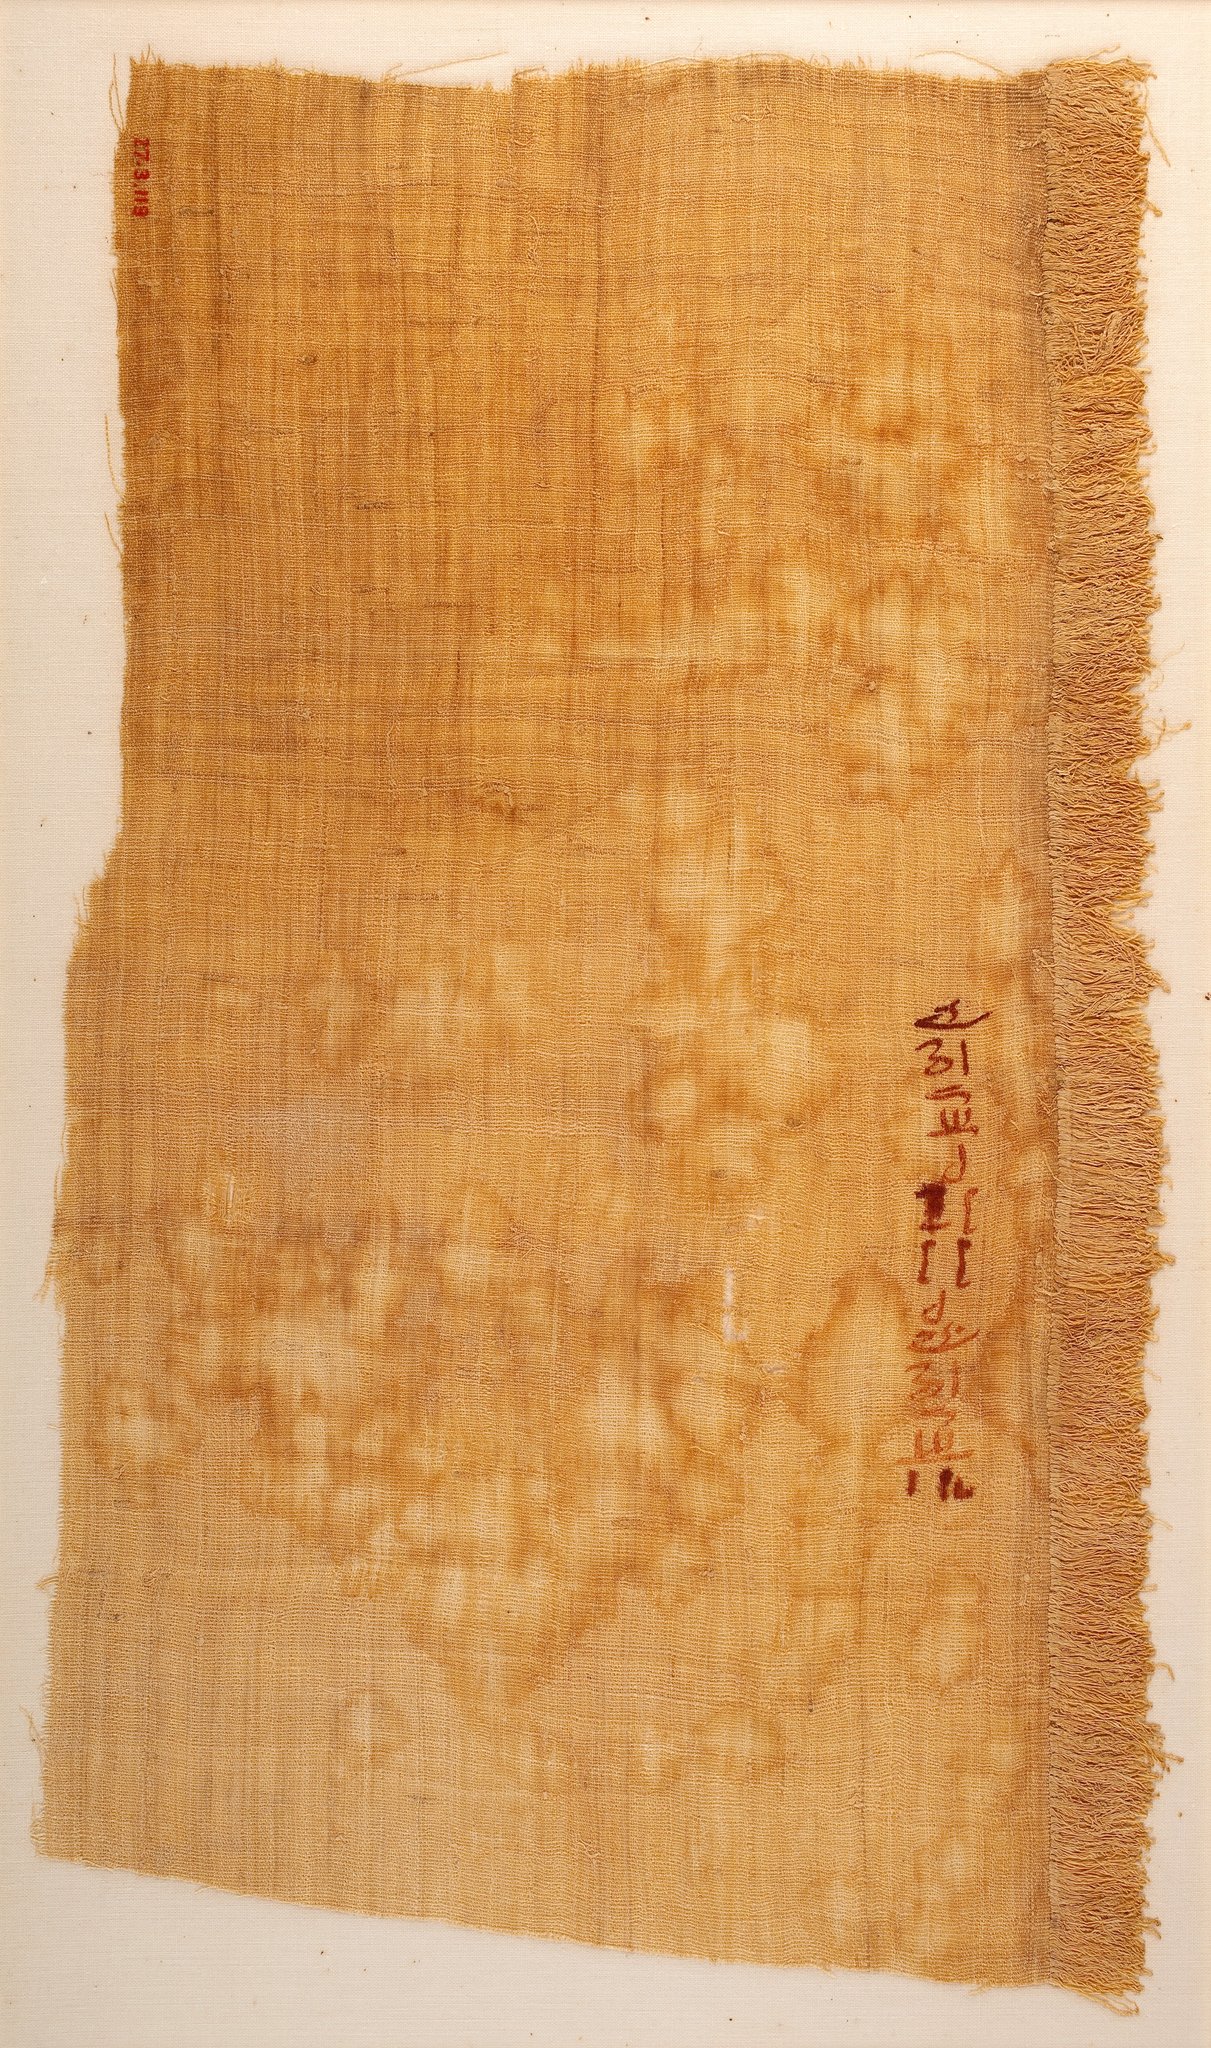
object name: linen mark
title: Linen mark (Type XX)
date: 1961-1917 BCE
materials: linen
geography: egypt